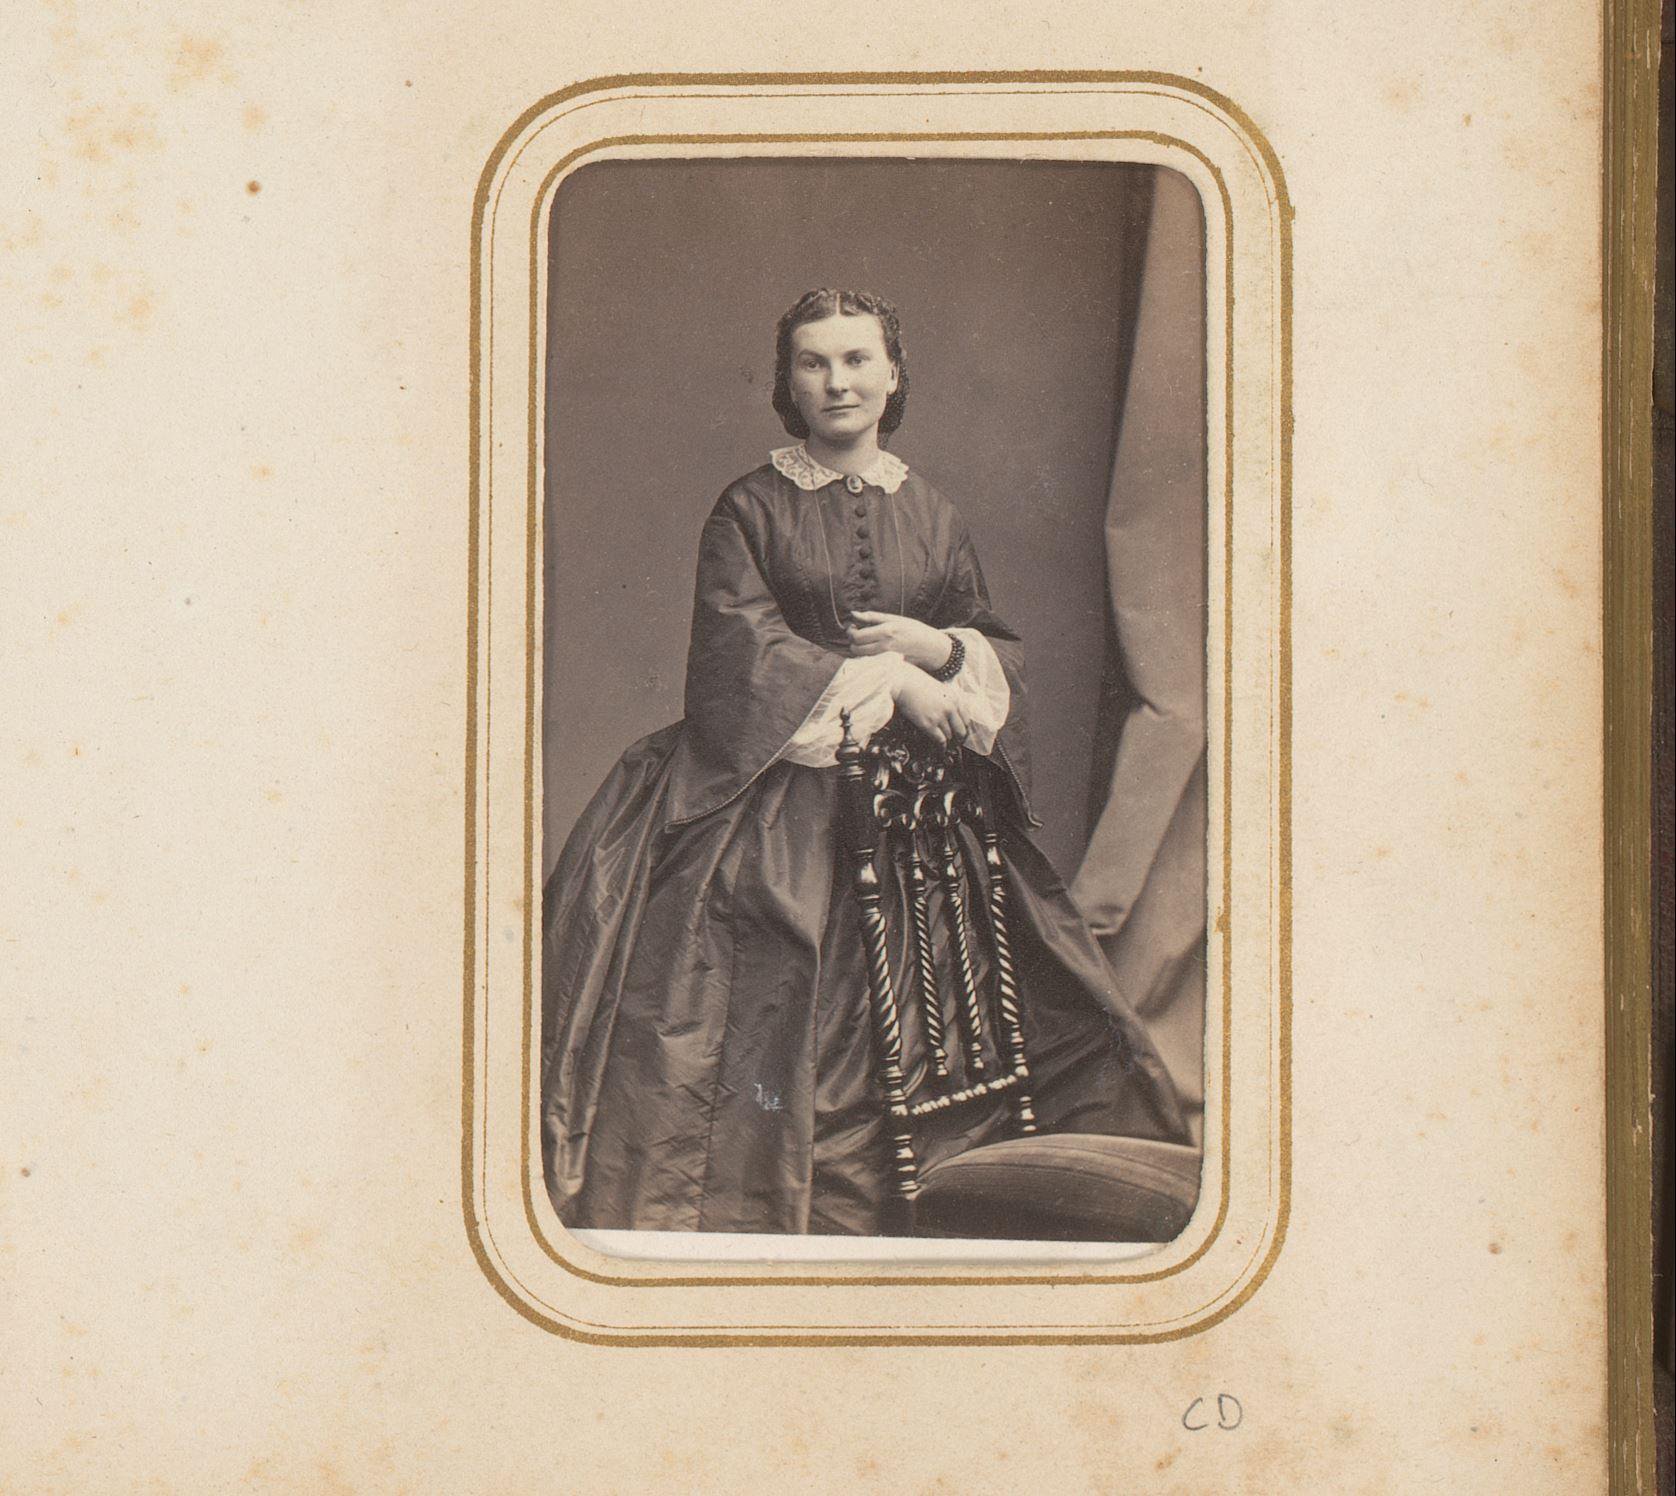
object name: photograph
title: Portret van een vrouw, staand bij een stoel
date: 1857-1864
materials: cardboard, photographic support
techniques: albumen print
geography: amsterdam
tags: historical persons - bb - woman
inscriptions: inscription: ‘Photogr. Atelier/ Wegner & Mottu/ Prinsengracht BB 439/ Amsterdam’